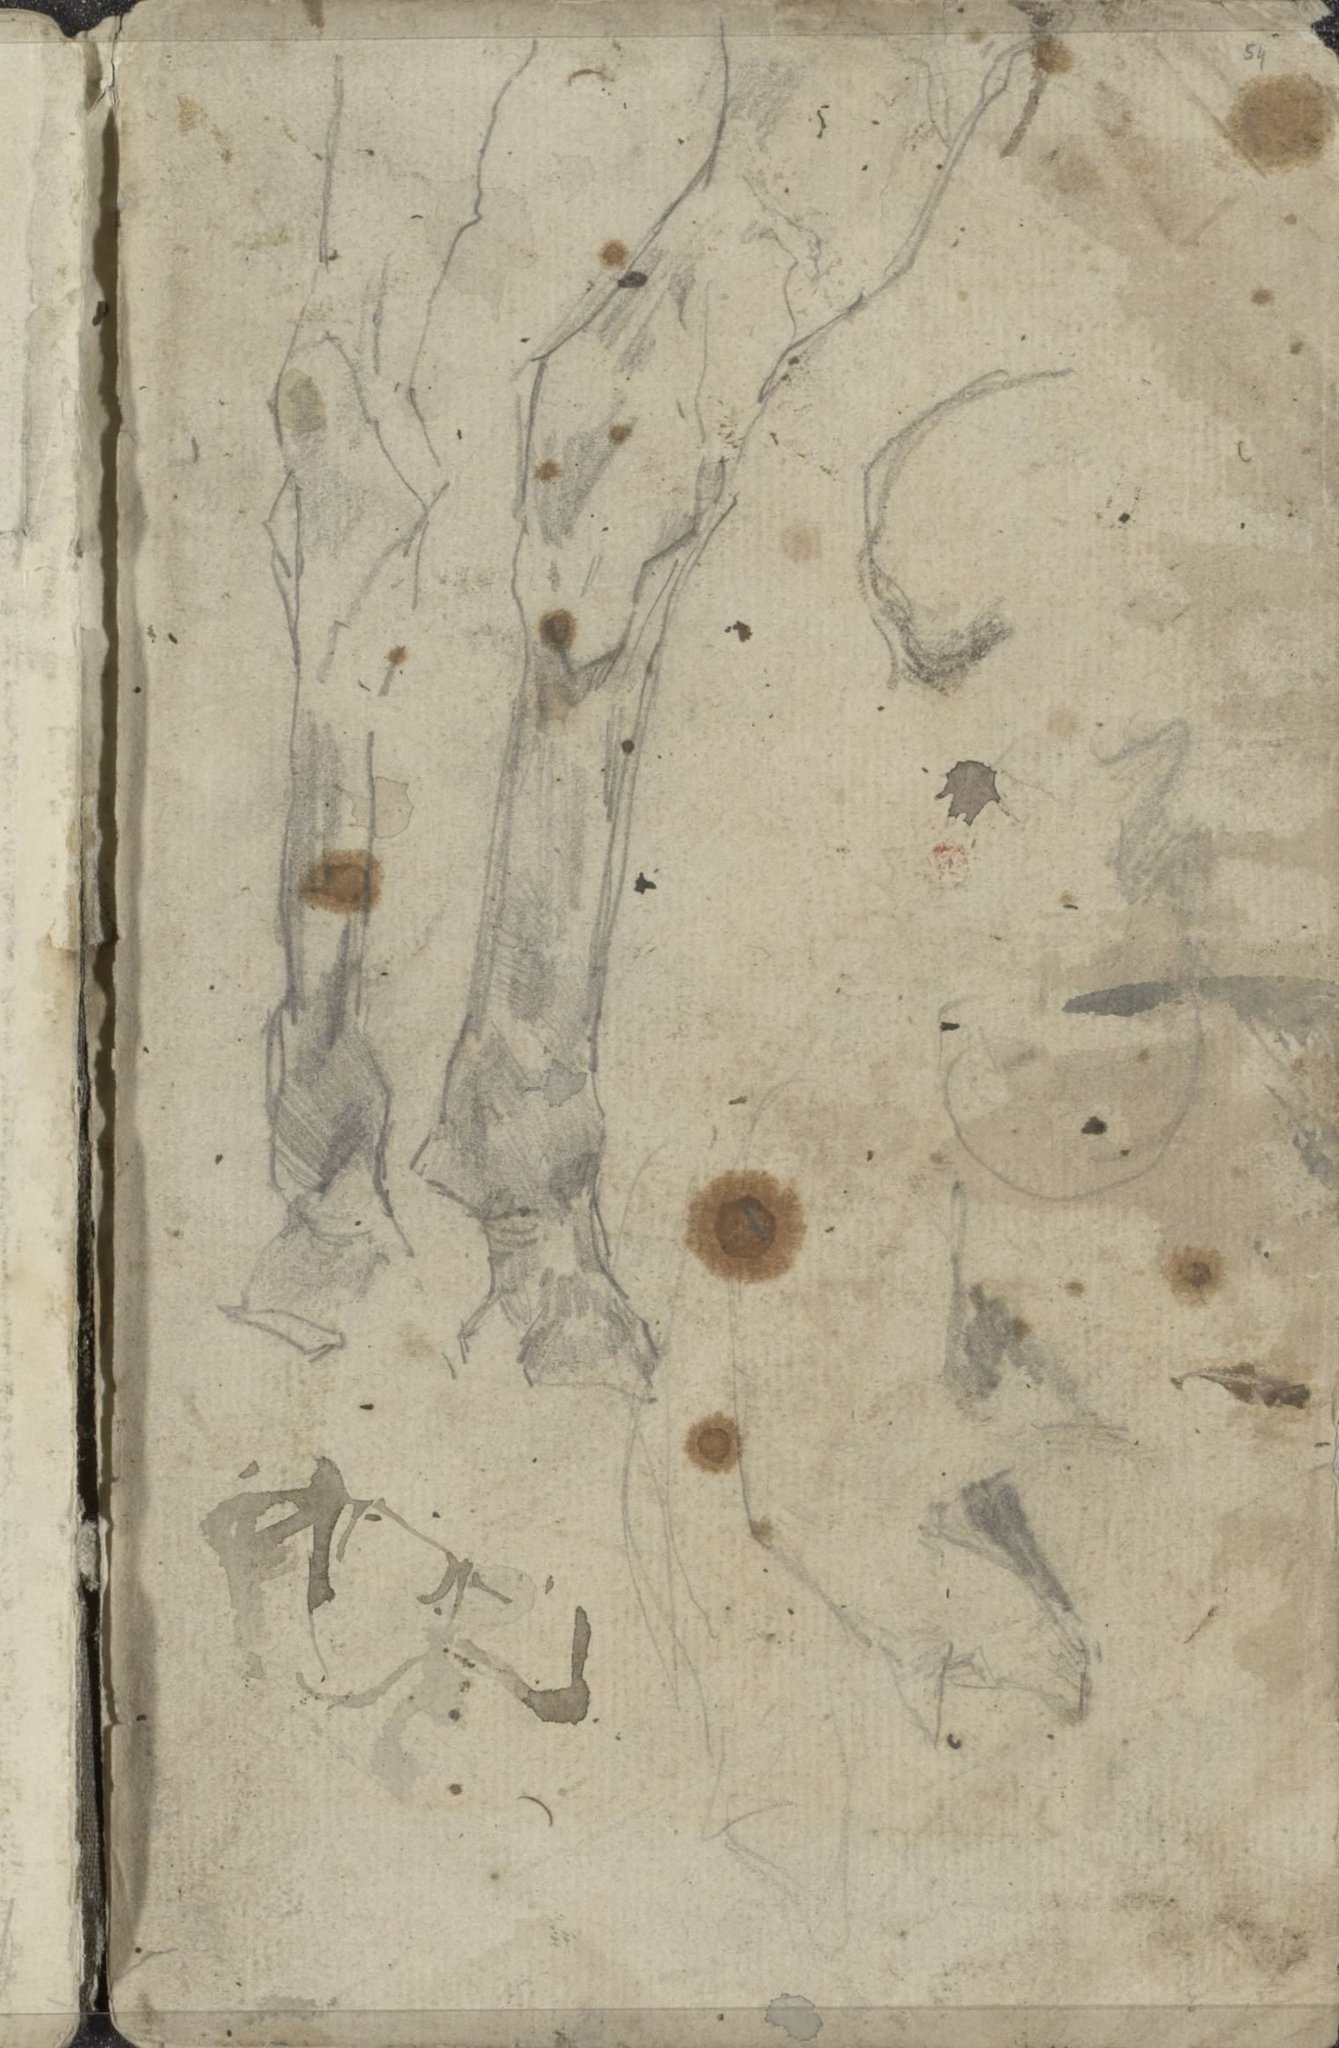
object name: sketchbook leaf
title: Varkens en paardenbenen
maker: george hendrik breitner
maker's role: draughtsman, painter, print maker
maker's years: 1857-1923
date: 1881-1883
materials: paper, pencil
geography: the hague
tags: pig, horse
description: Pagina 54 uit een schetsboek met 27 bladen